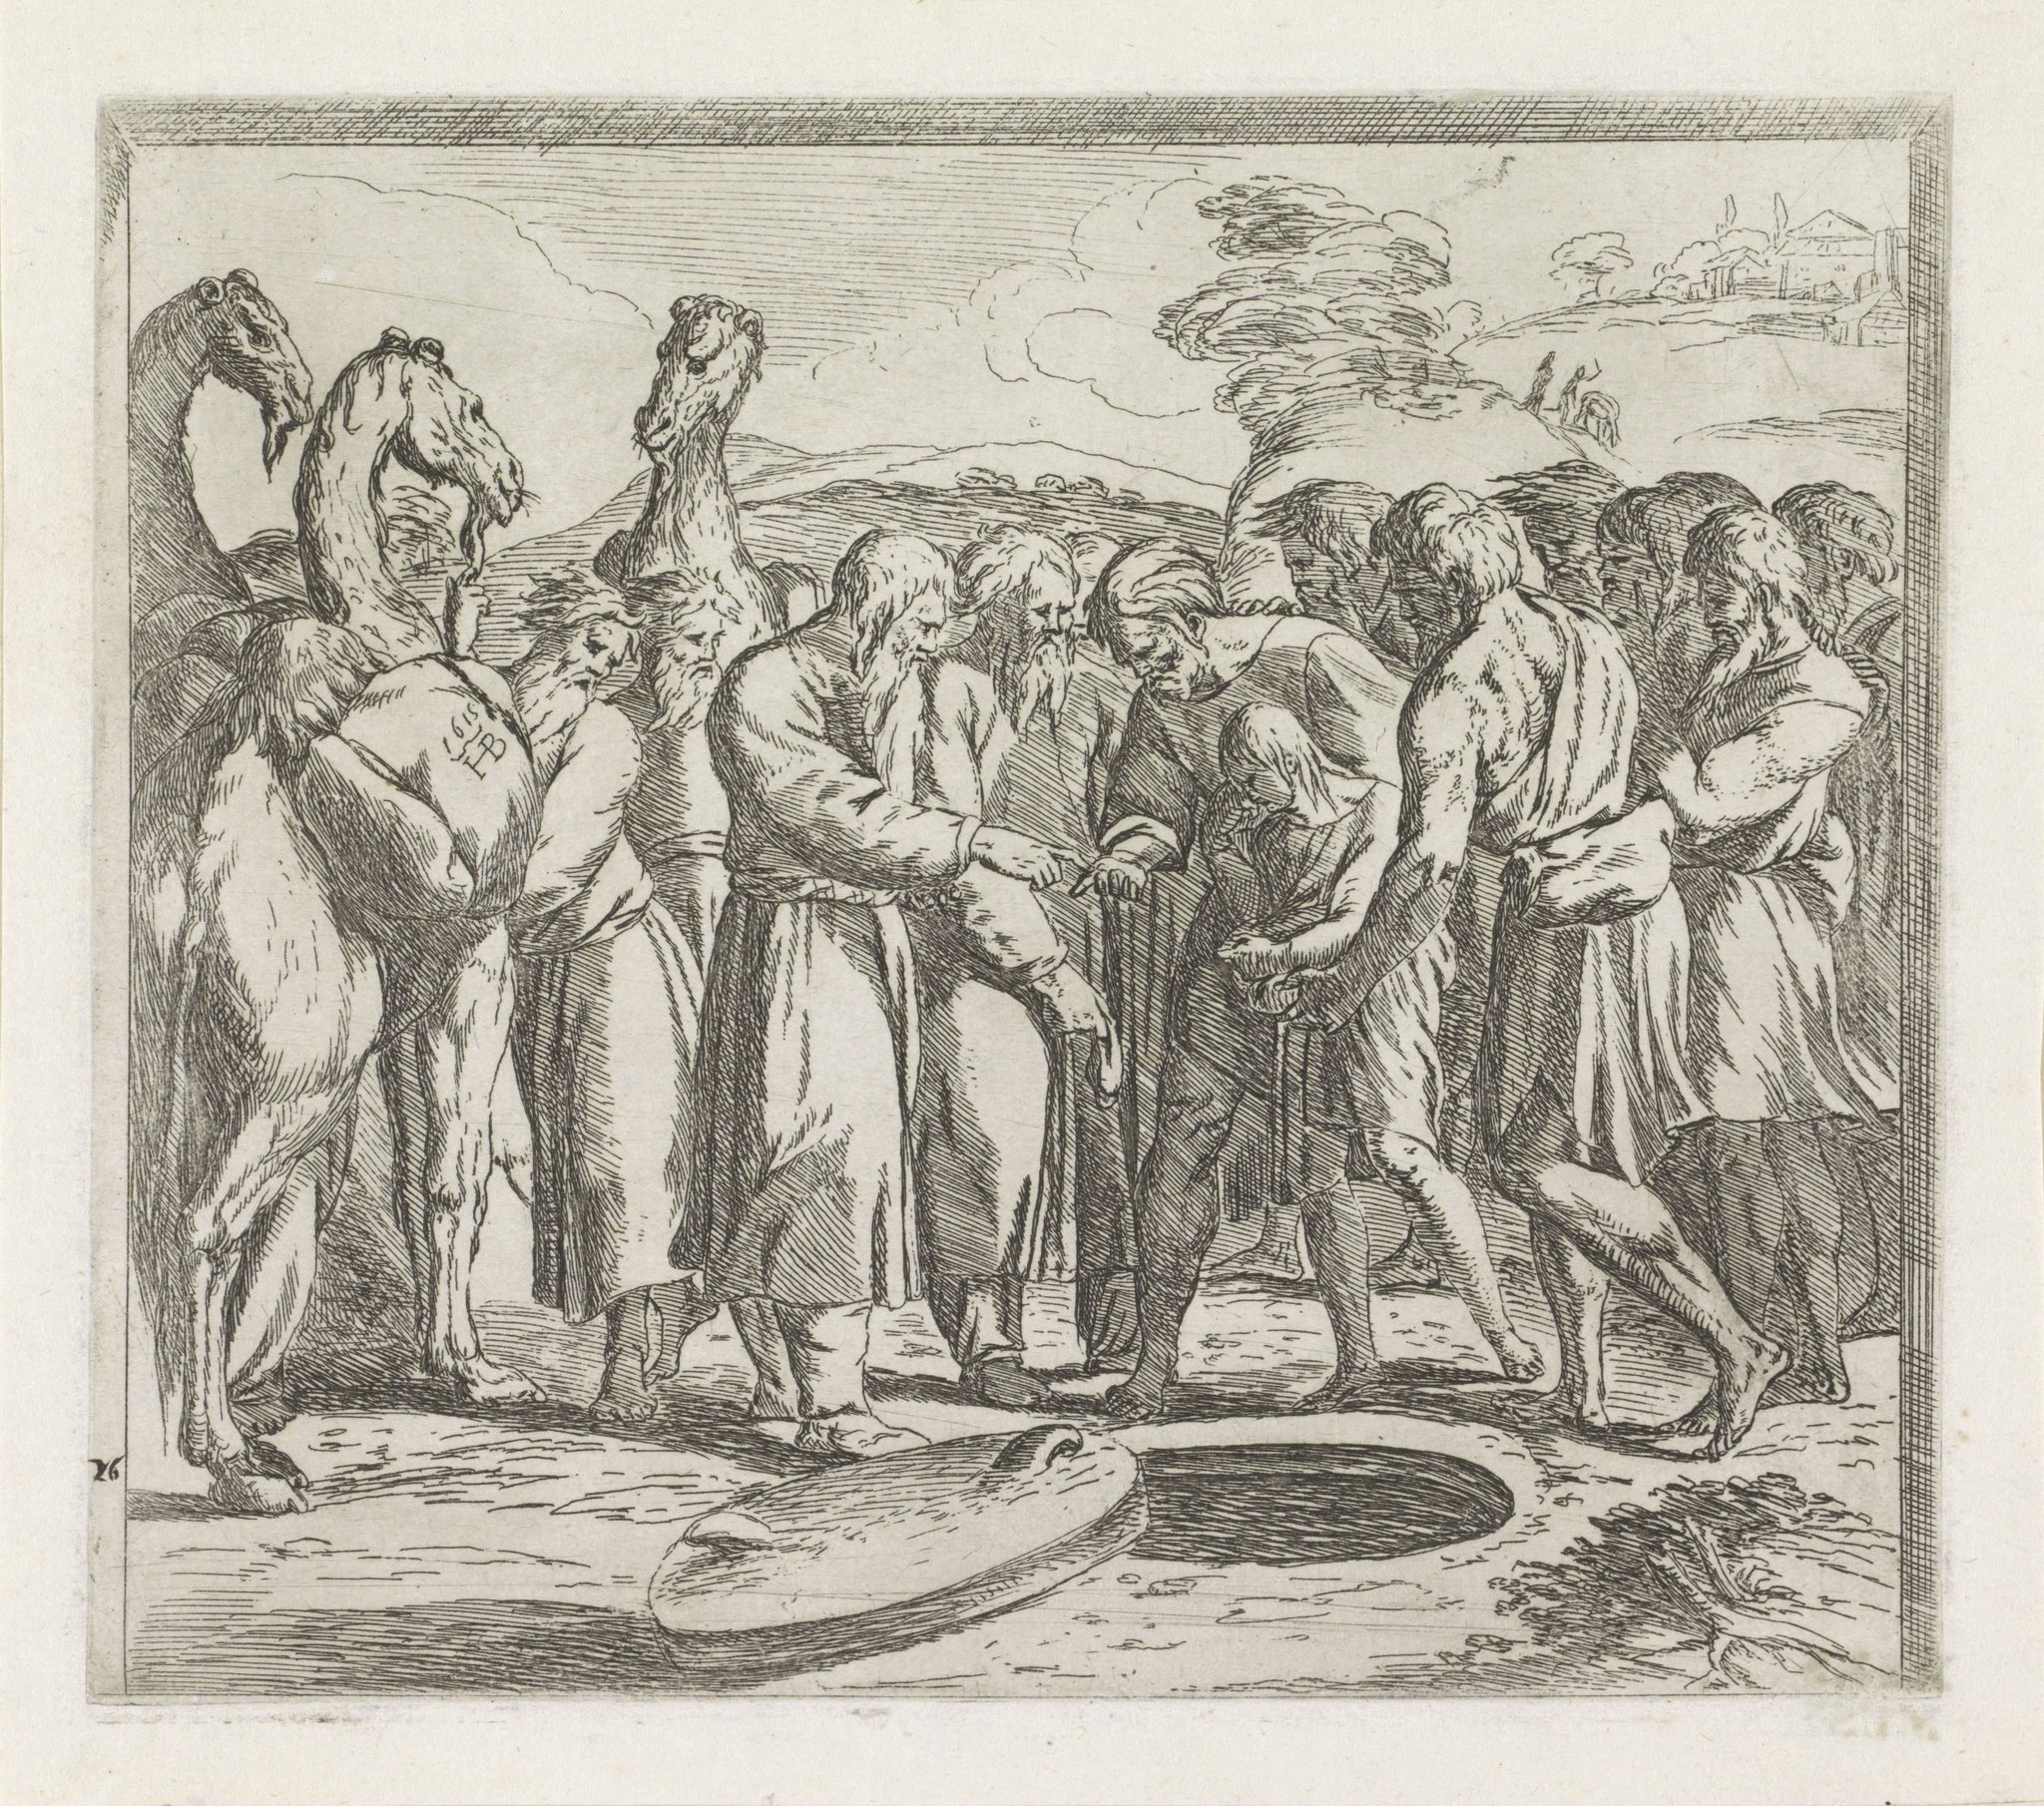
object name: print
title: Jozef door zijn broers verkocht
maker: orazio borgianni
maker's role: print maker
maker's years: 1578-1616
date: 1615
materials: paper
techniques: etching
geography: italy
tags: joseph is sold to potiphar, joseph is sold for twenty pieces of silver, joseph sold into slavery and taken to egypt (genesis 37:12-35)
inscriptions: collector's mark: Lugt 2165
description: Prent uit een reeks van 52 prenten naar schilderingen in de Loggia van Rafaël in het Vaticaan.